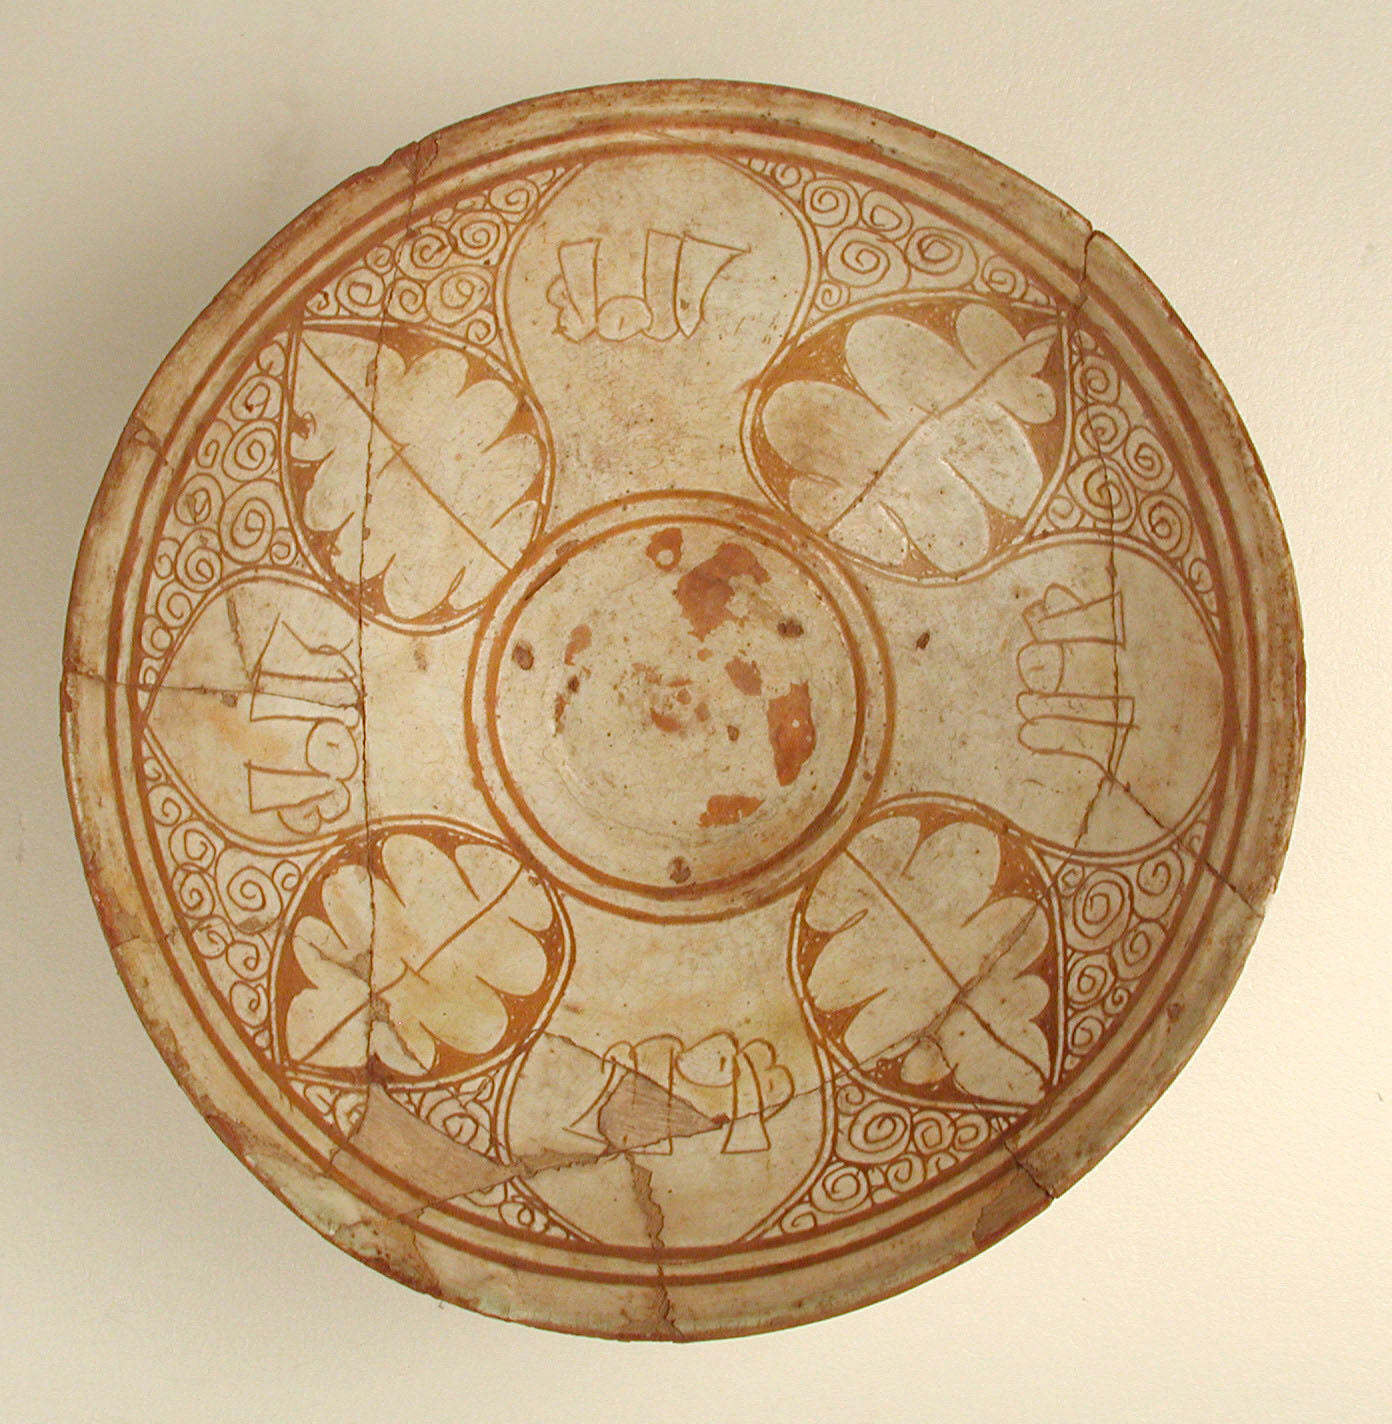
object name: bowl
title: Bowl with Incised Decoration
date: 1001-1100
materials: earthenware, glaze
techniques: incising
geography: iran